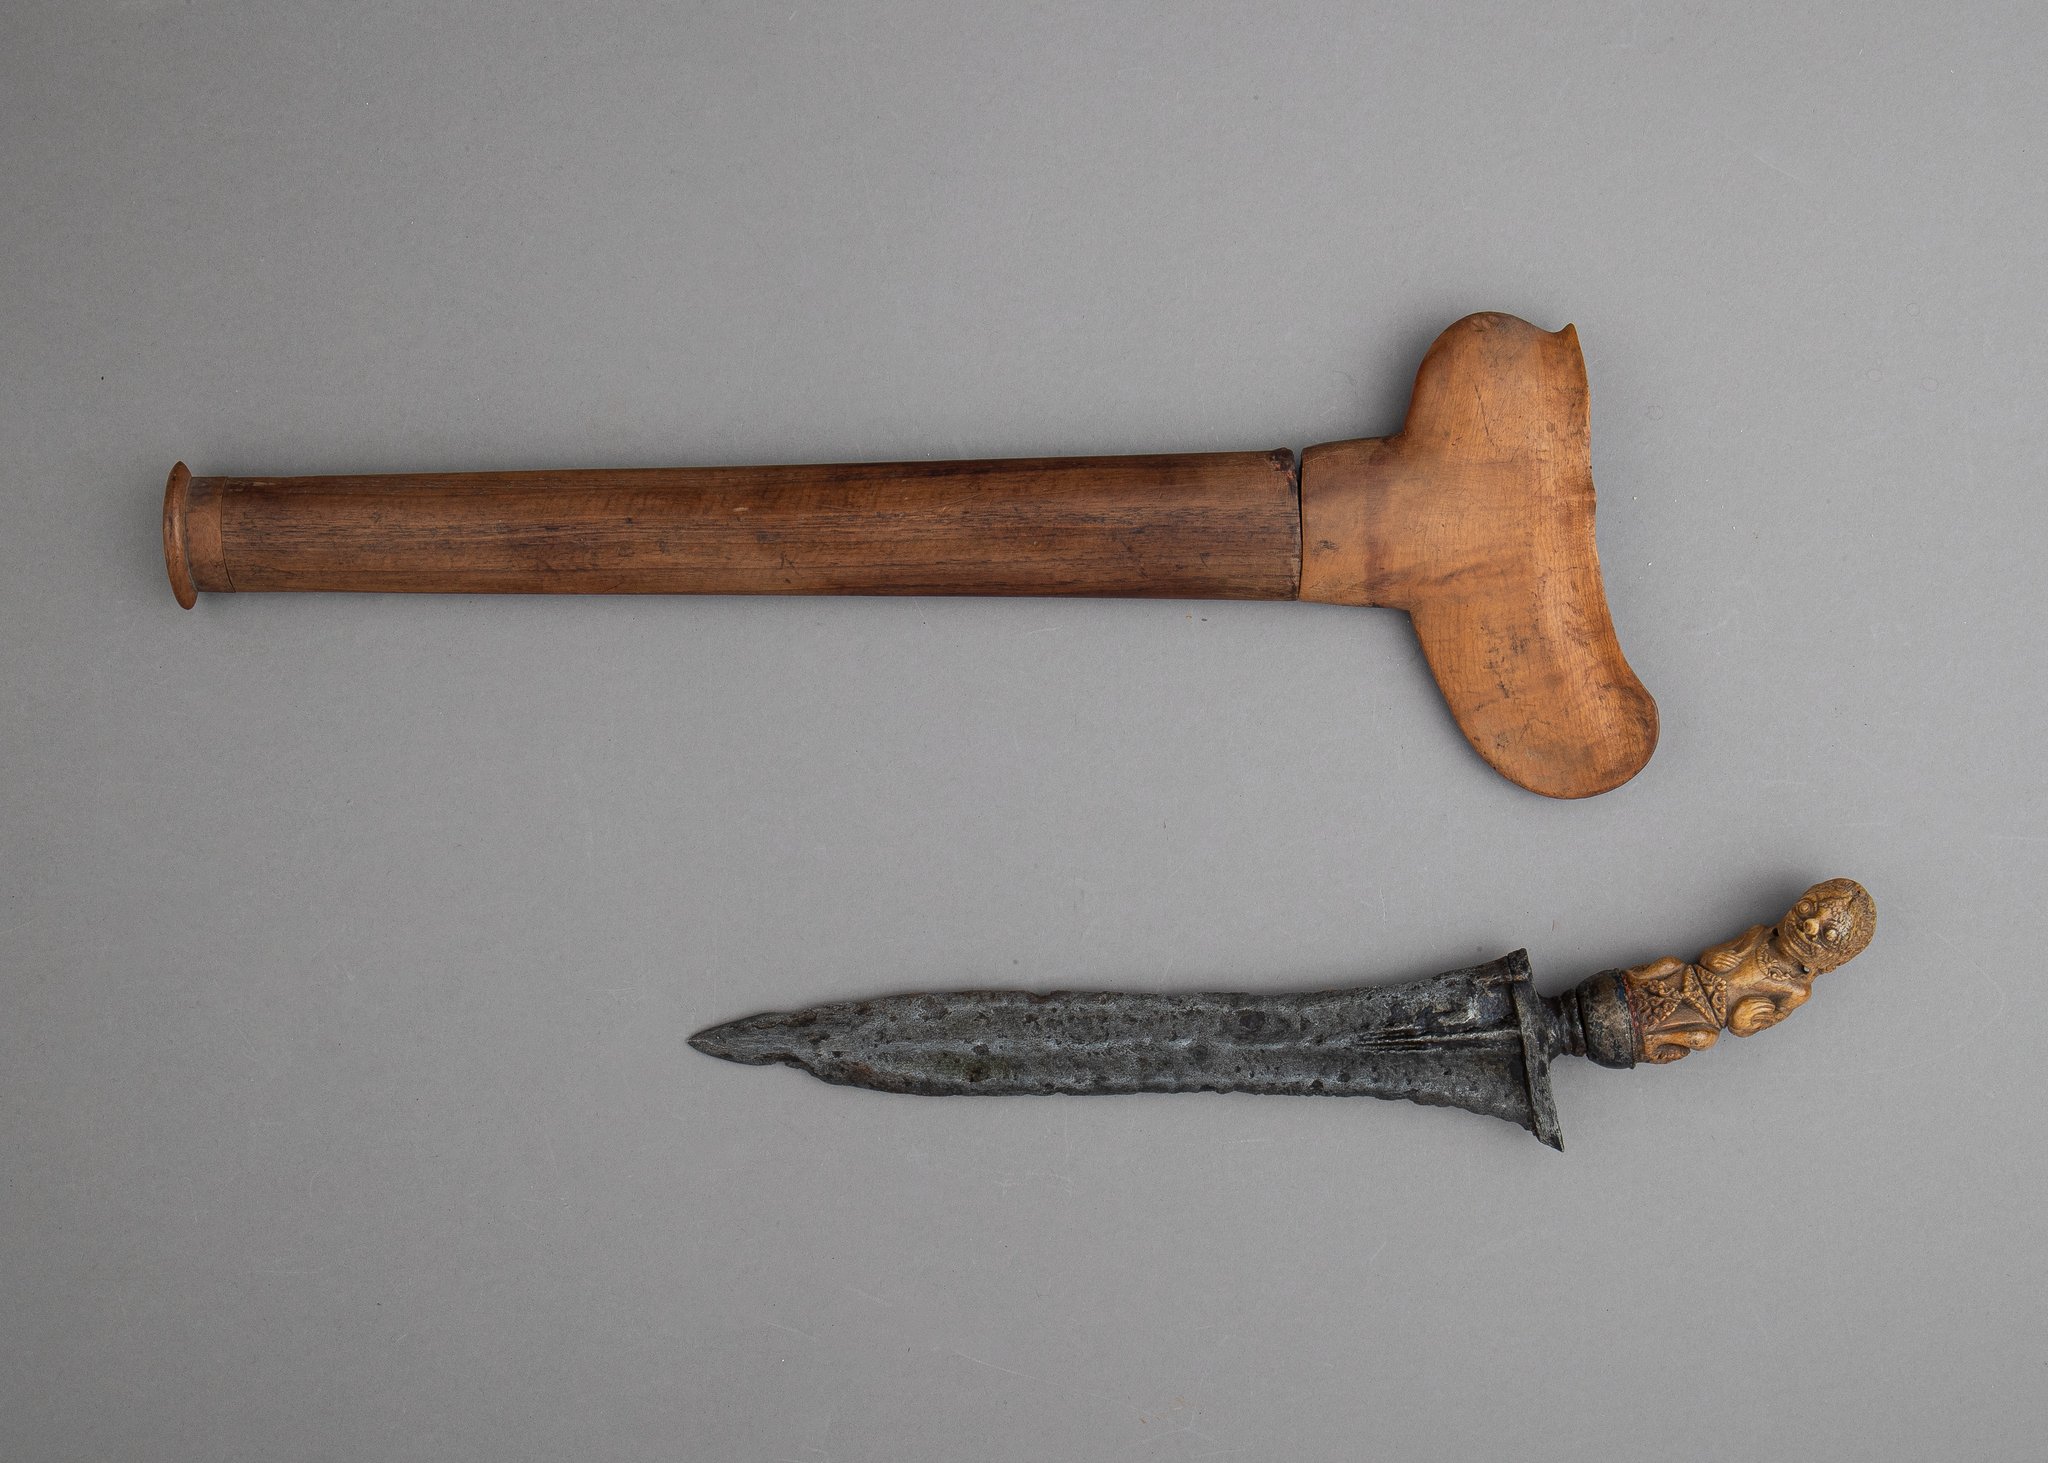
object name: kris with sheath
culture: javanese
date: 1501-1900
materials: bone, silver, steel, wood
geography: indonesia